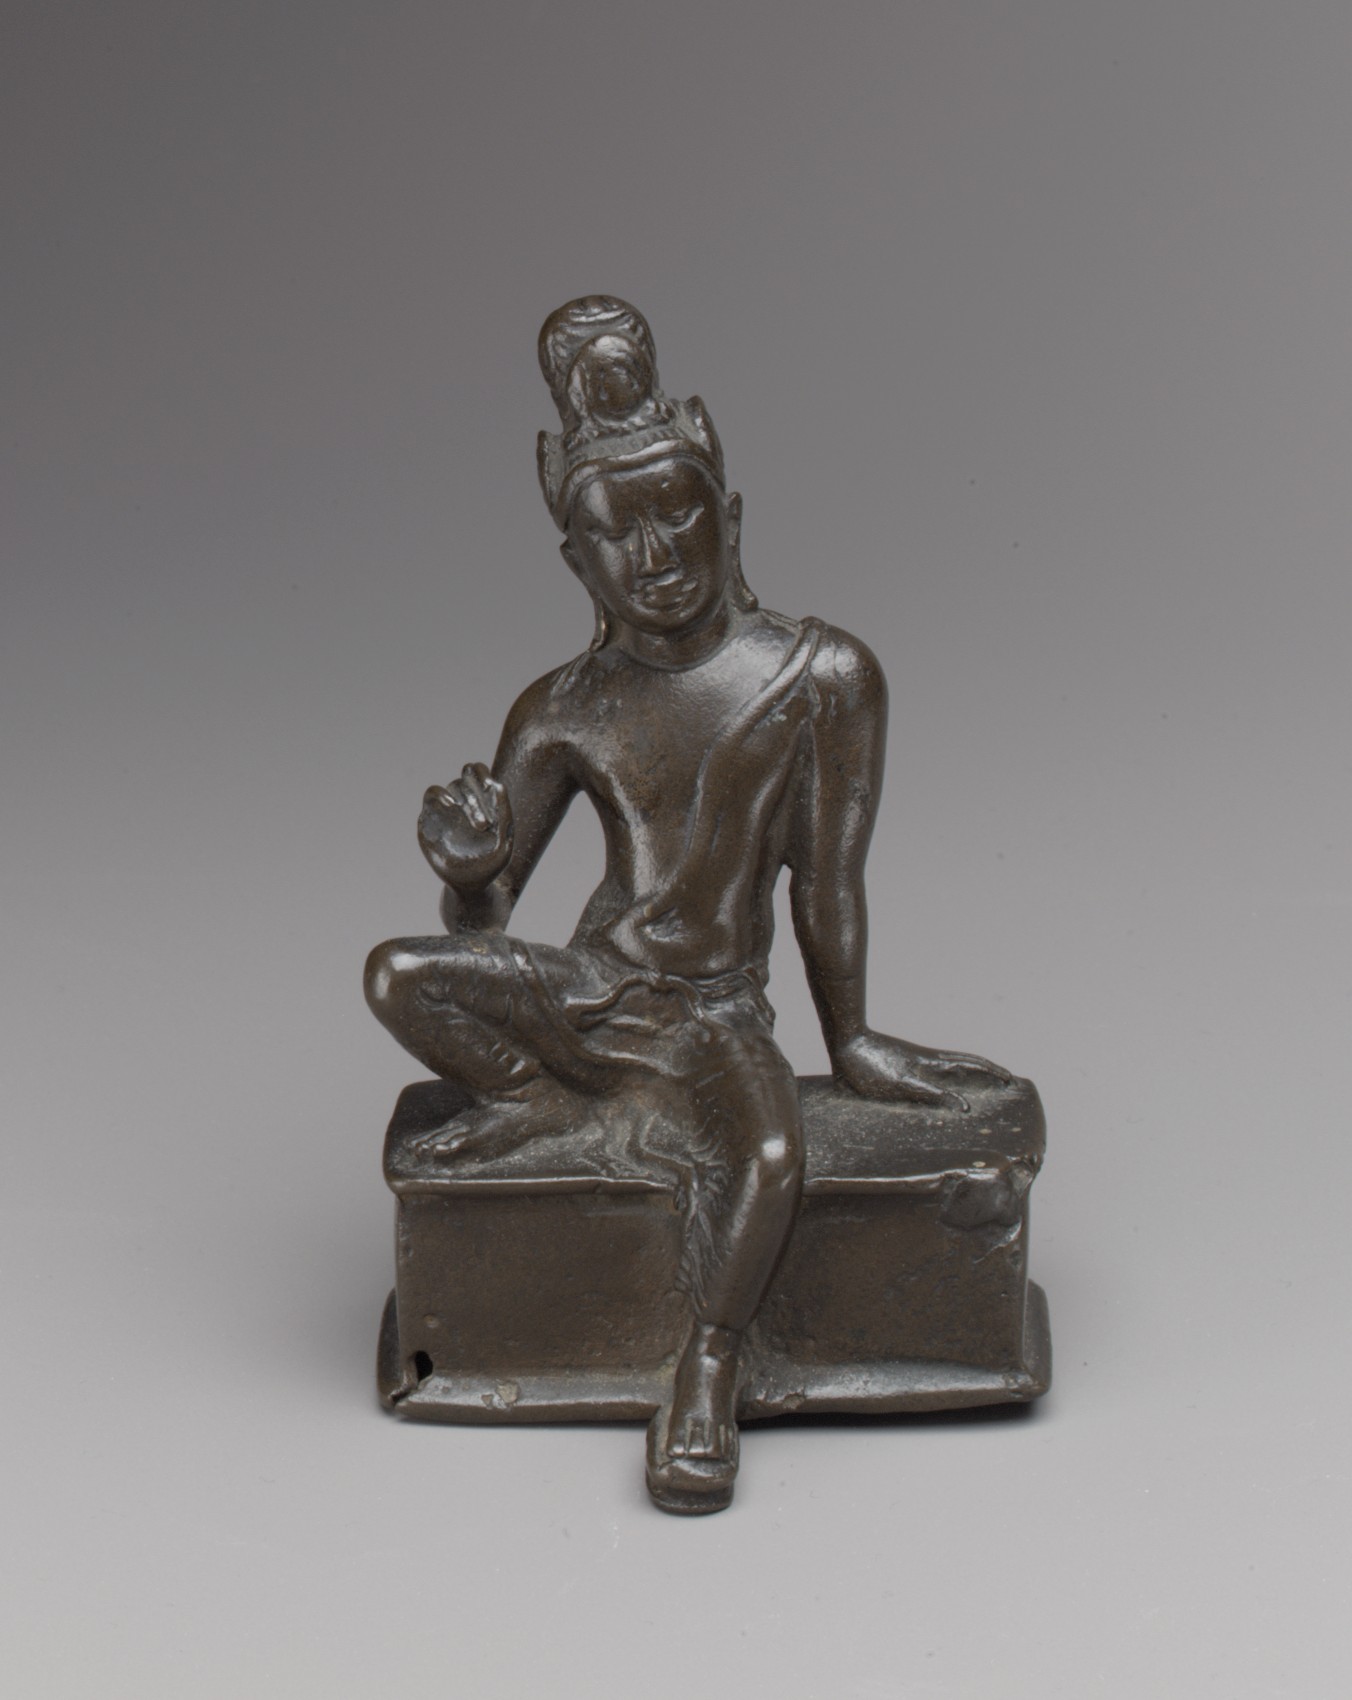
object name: figurine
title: Avalokiteshvara, the Bodhisattva of Infinite Compassion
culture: sri lankan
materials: bronze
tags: buddhism,avalokiteshvara,bodhisattvas